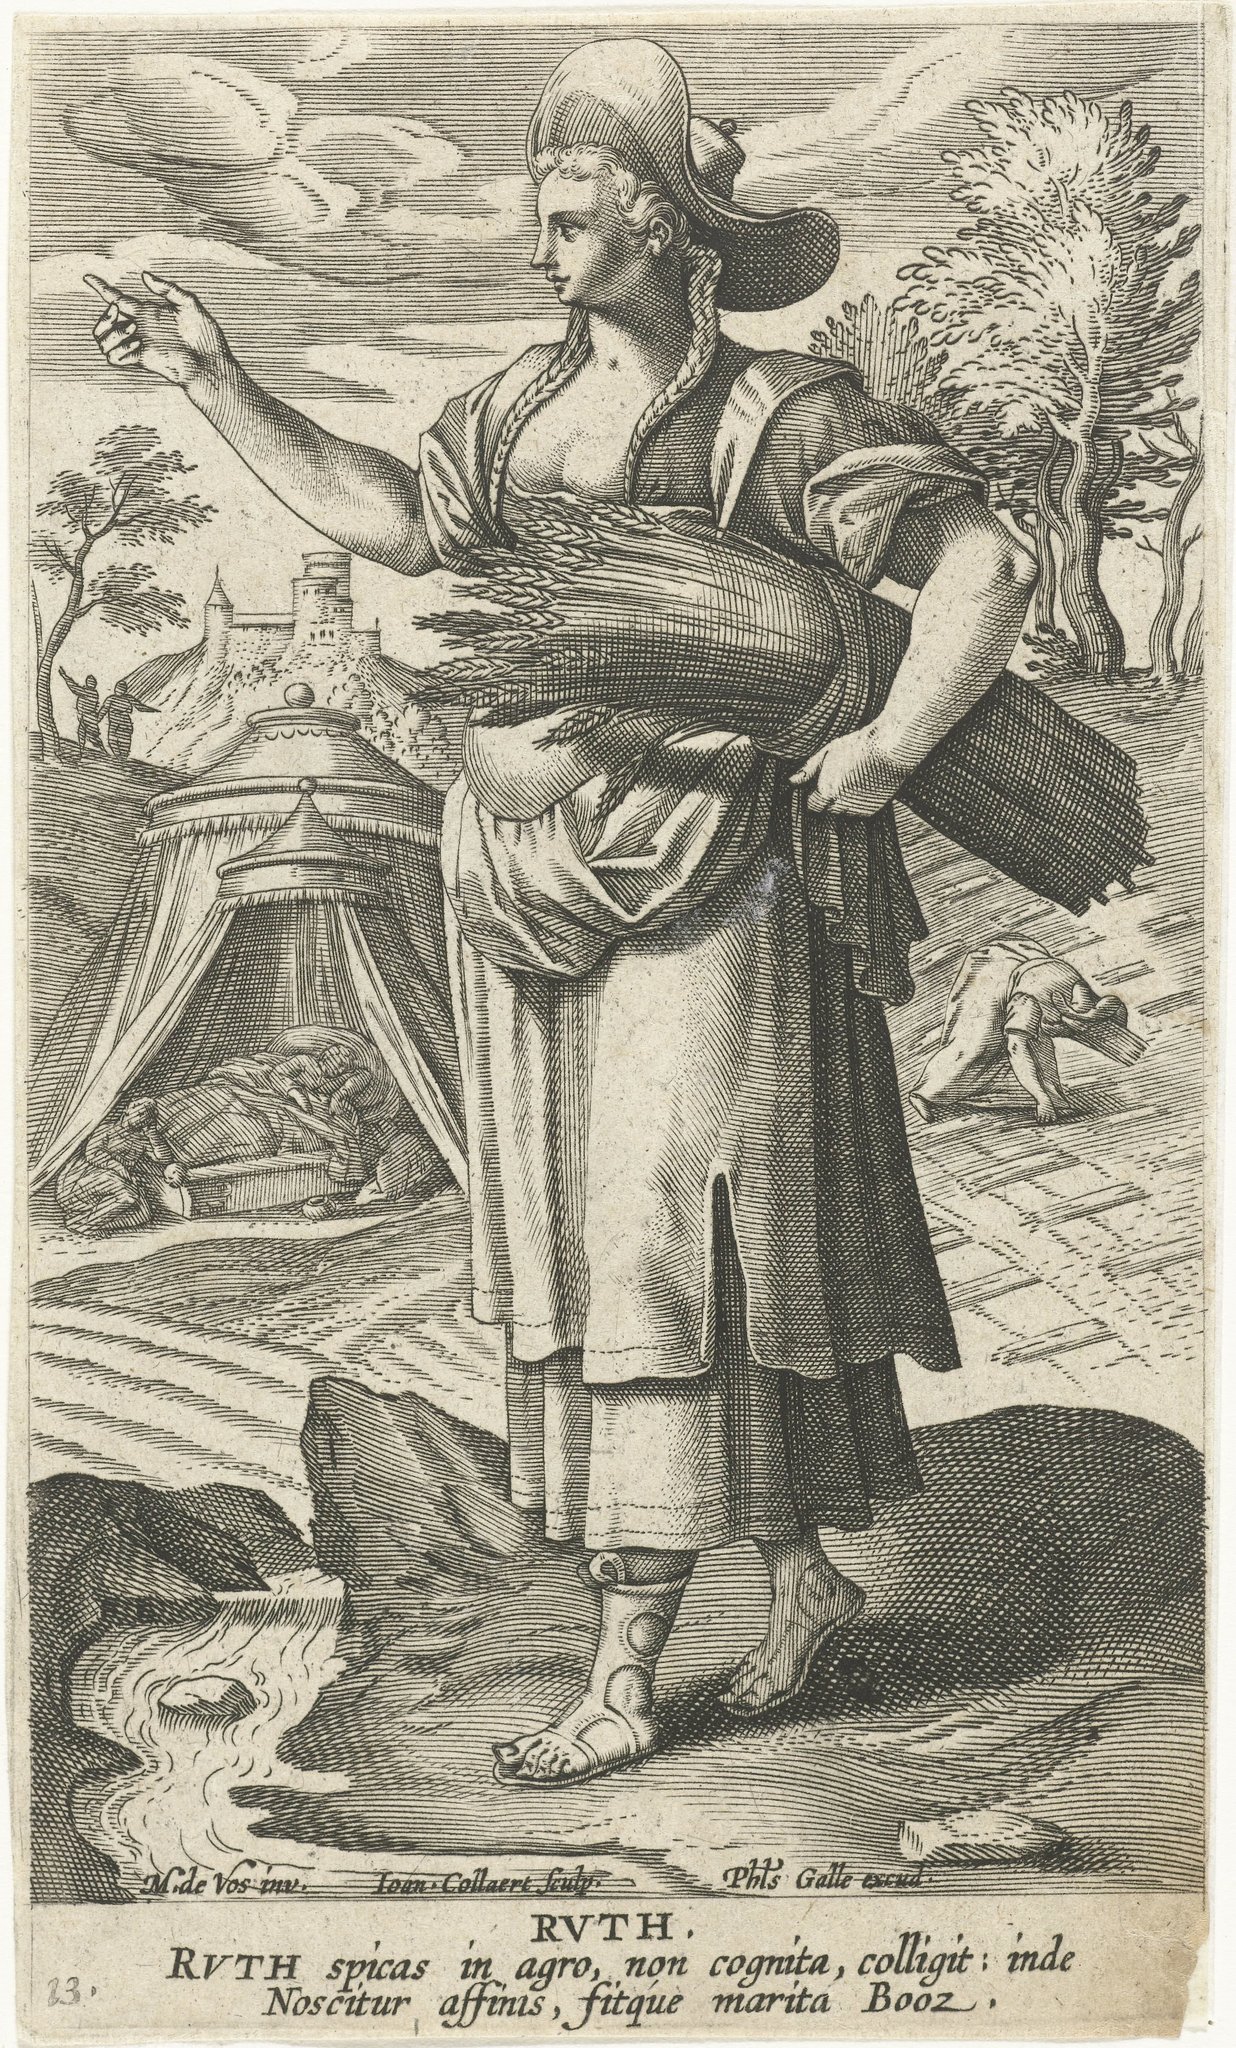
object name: print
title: Ruth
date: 1588-1595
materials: paper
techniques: engraving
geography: antwerp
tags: ruth in the field of boaz (ruth 2:3-17), ruth invited by boaz to eat with him, female persons from the old testament (with name) (not in biblical context)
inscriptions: collector's mark: Lugt 2228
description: Op de voorgrond Ruth met een bundel aren onder haar arm. Op de achtergrond raapt ze aren op een akker en wordt ze naar de tent van Boaz gehaald. De prent heeft een Latijns onderschrift en maakt deel uit van een prentserie met beroemde vrouwen uit het Oude Testament.